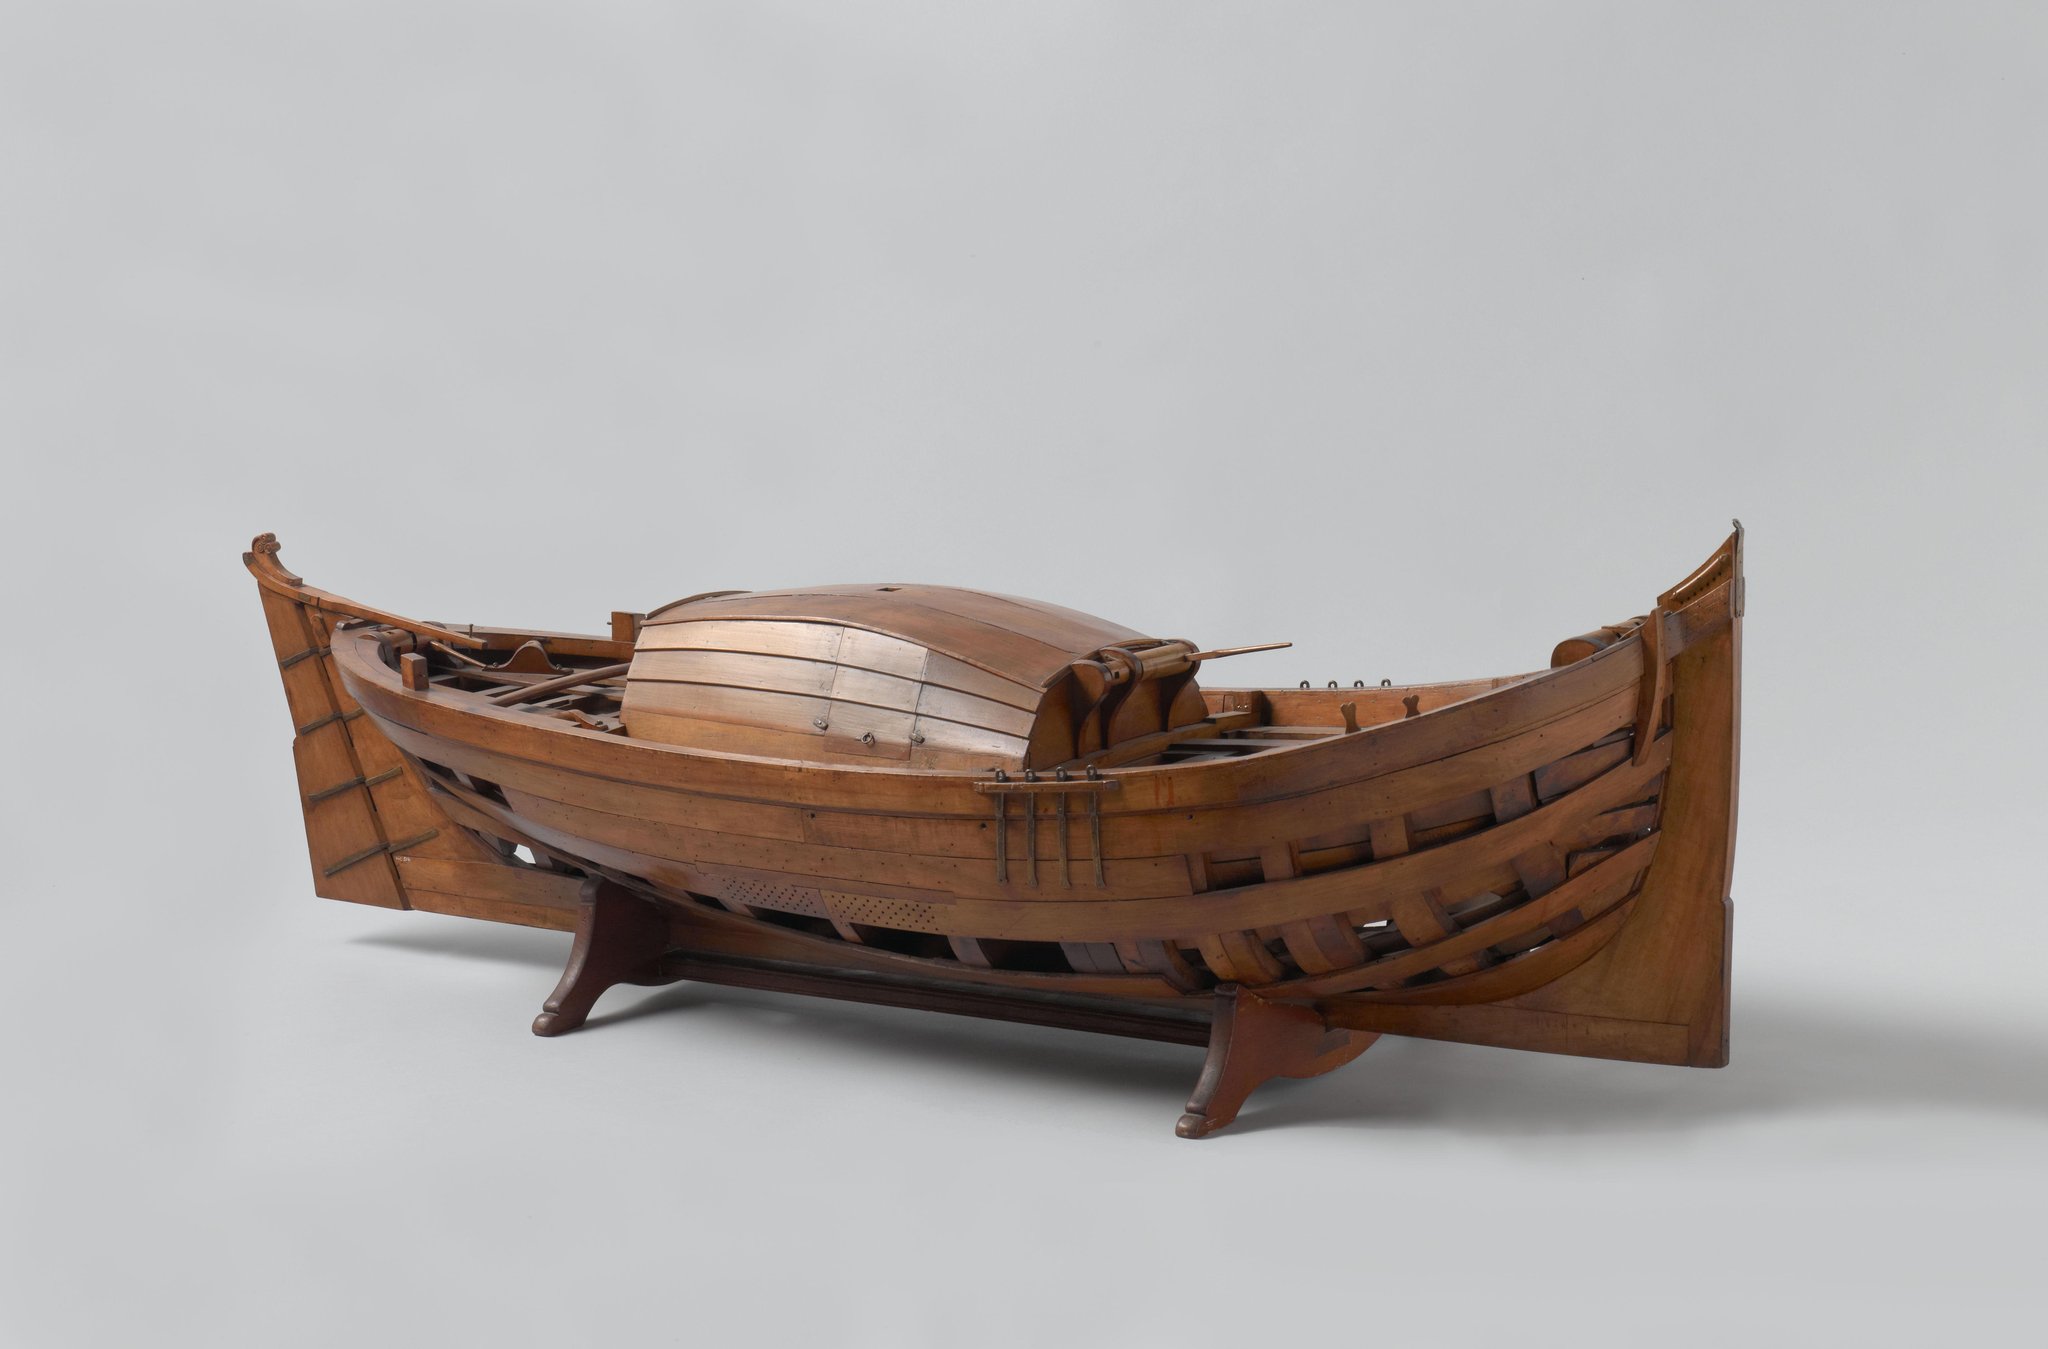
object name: ship model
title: Model of a Marker Waterschip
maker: Anonymous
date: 1800-1858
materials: brass, wood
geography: netherlands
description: Marker waterschepen waren visserschepen, qua vorm waarschijnlijk afgeleid van de botter, maar zonder zwaarden. Zij visten met sleepnetten en waren snelle zeilers. Vanaf de 17de eeuw werden zij ook gebruikt voor het slepen van scheepskamelen over Pampus. Het ontwerp stamt al uit de late Middeleeuwen (toen zwaarden hier nog niet waren uitgevonden) en is onveranderd toegepast tot in het begin van de negentiende eeuw, toen de Marine nog een stel liet bouwen om de scheepskamelen te trekken, waarmee grote oorlogs- en koopvaardijschepen over de ondiepten van de Zuiderzee werden getrokken. Vijf waterschepen op een rij presteerden het om schepen door een meter modder te trekken. Als vissers visten zij met sleepnetten en waren snelle zeilers.